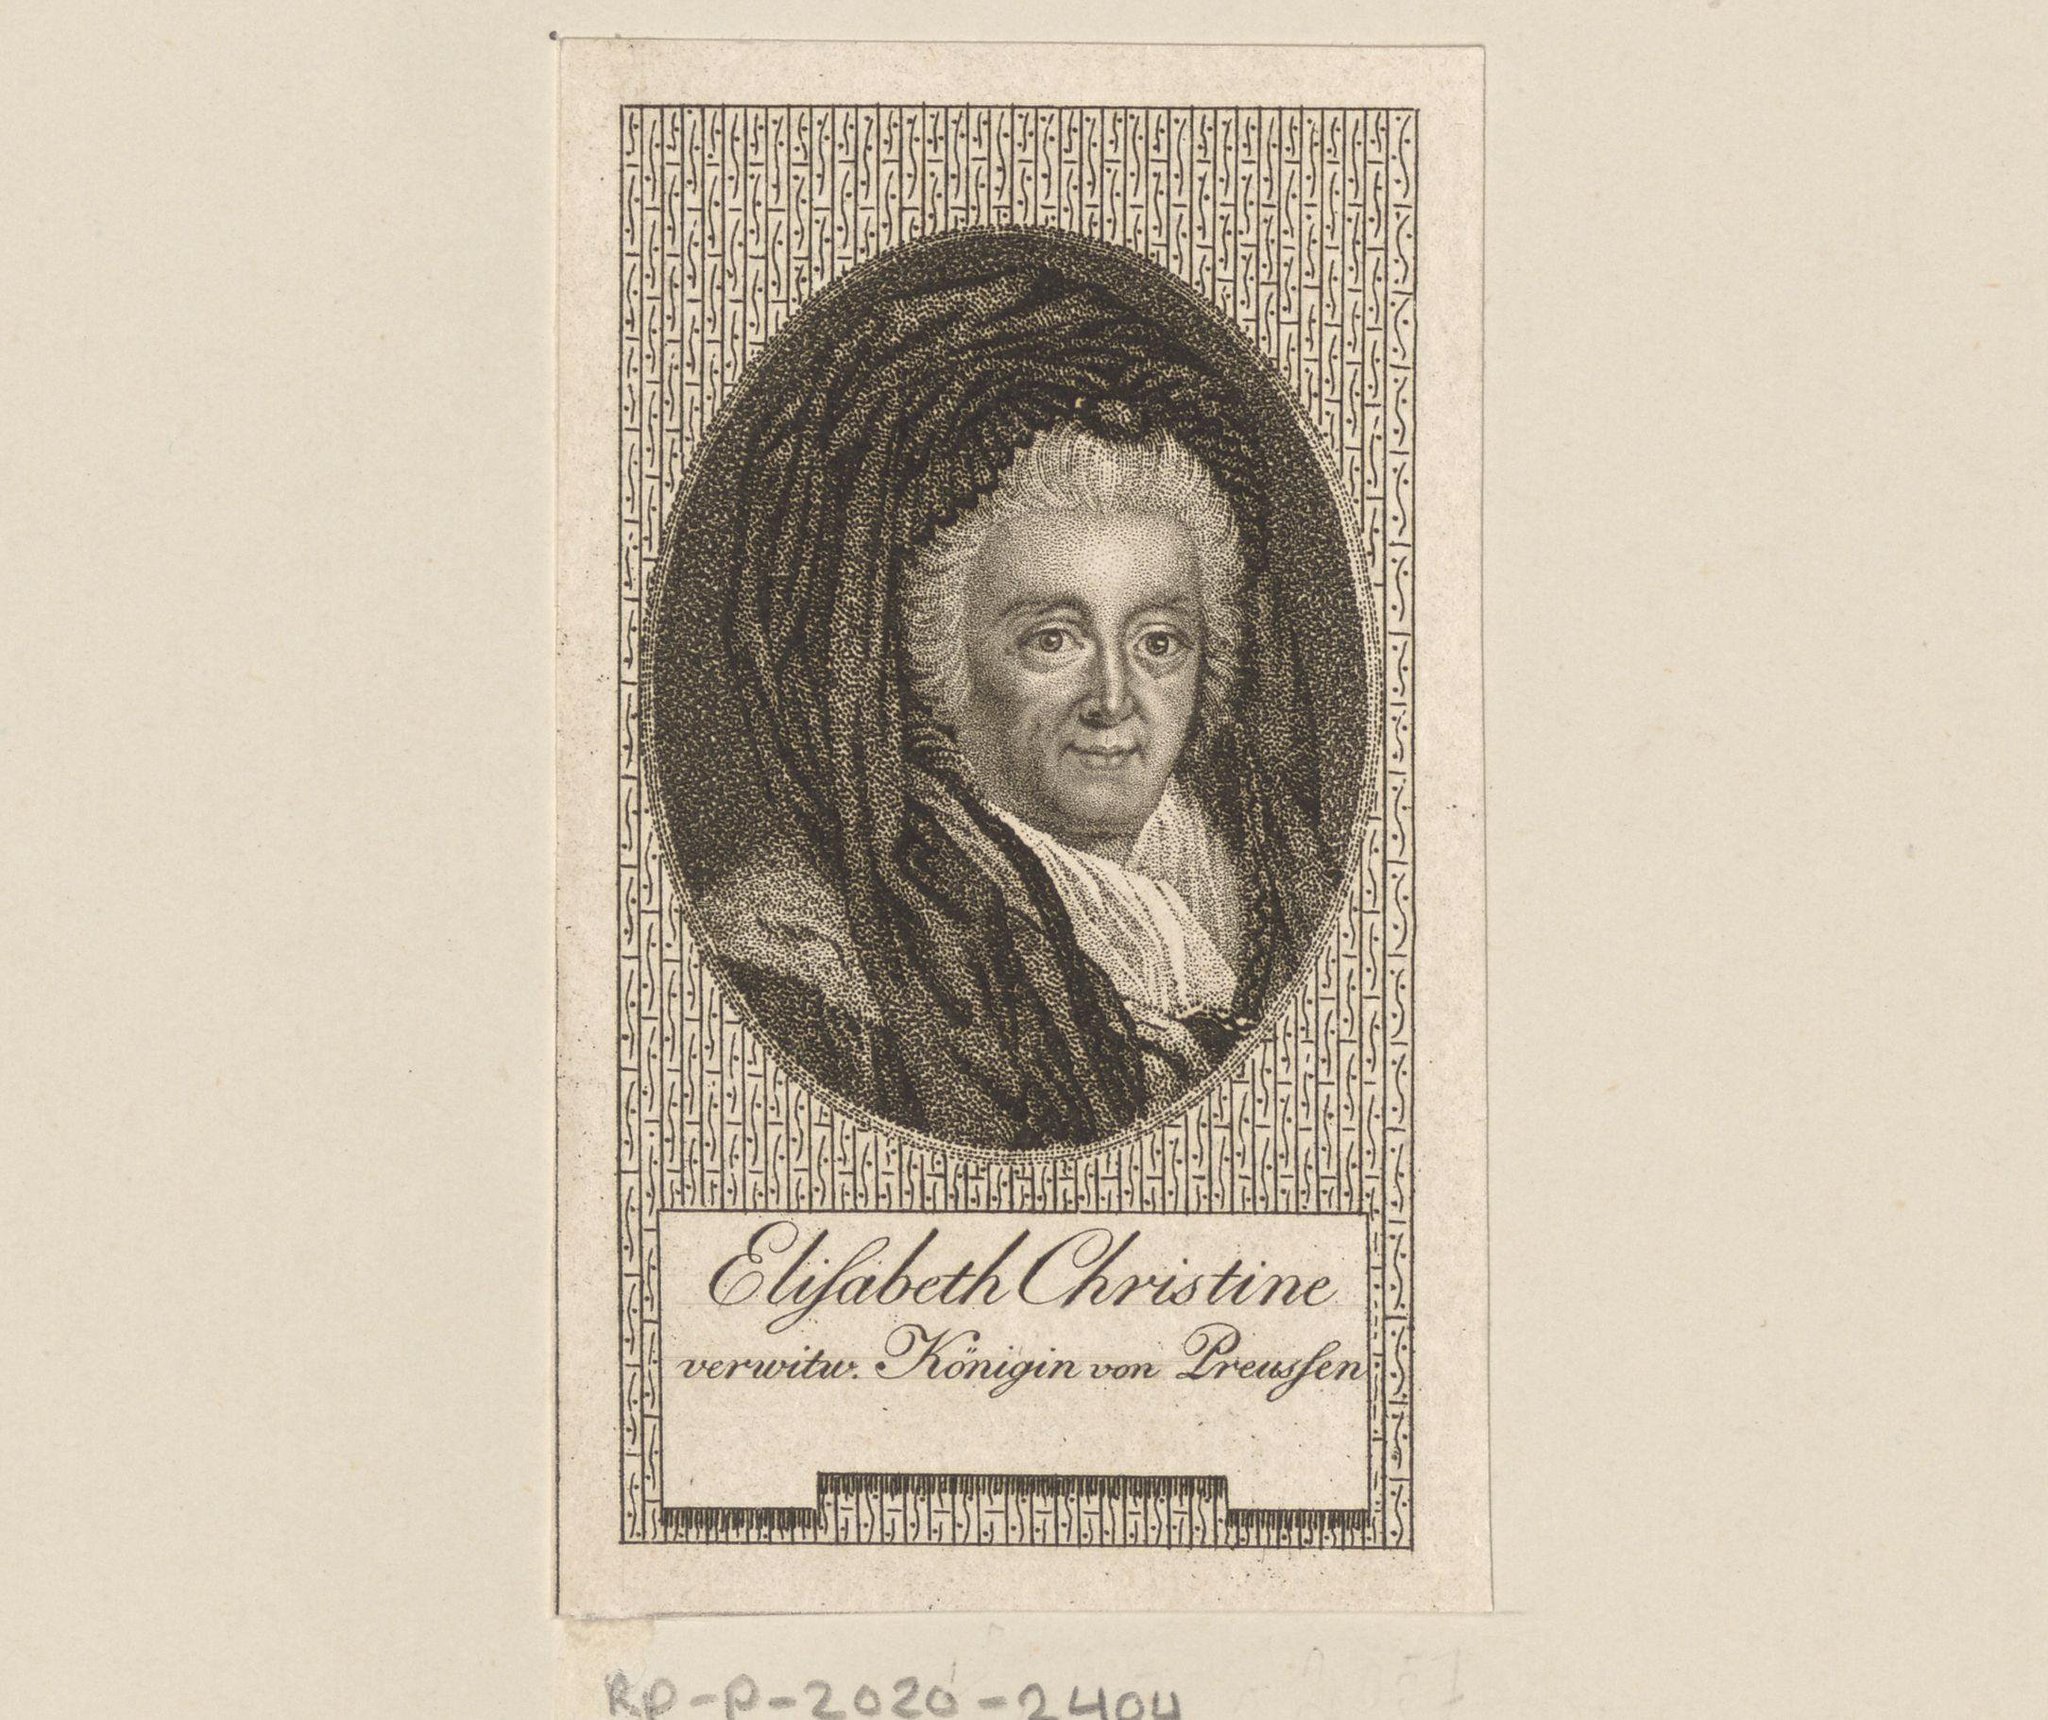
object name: print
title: Portret van Elisabeth Christine van Brunswijk-Bevern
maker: Anonymous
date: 1786-1797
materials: paper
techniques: etching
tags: historical persons - bb - woman, widow